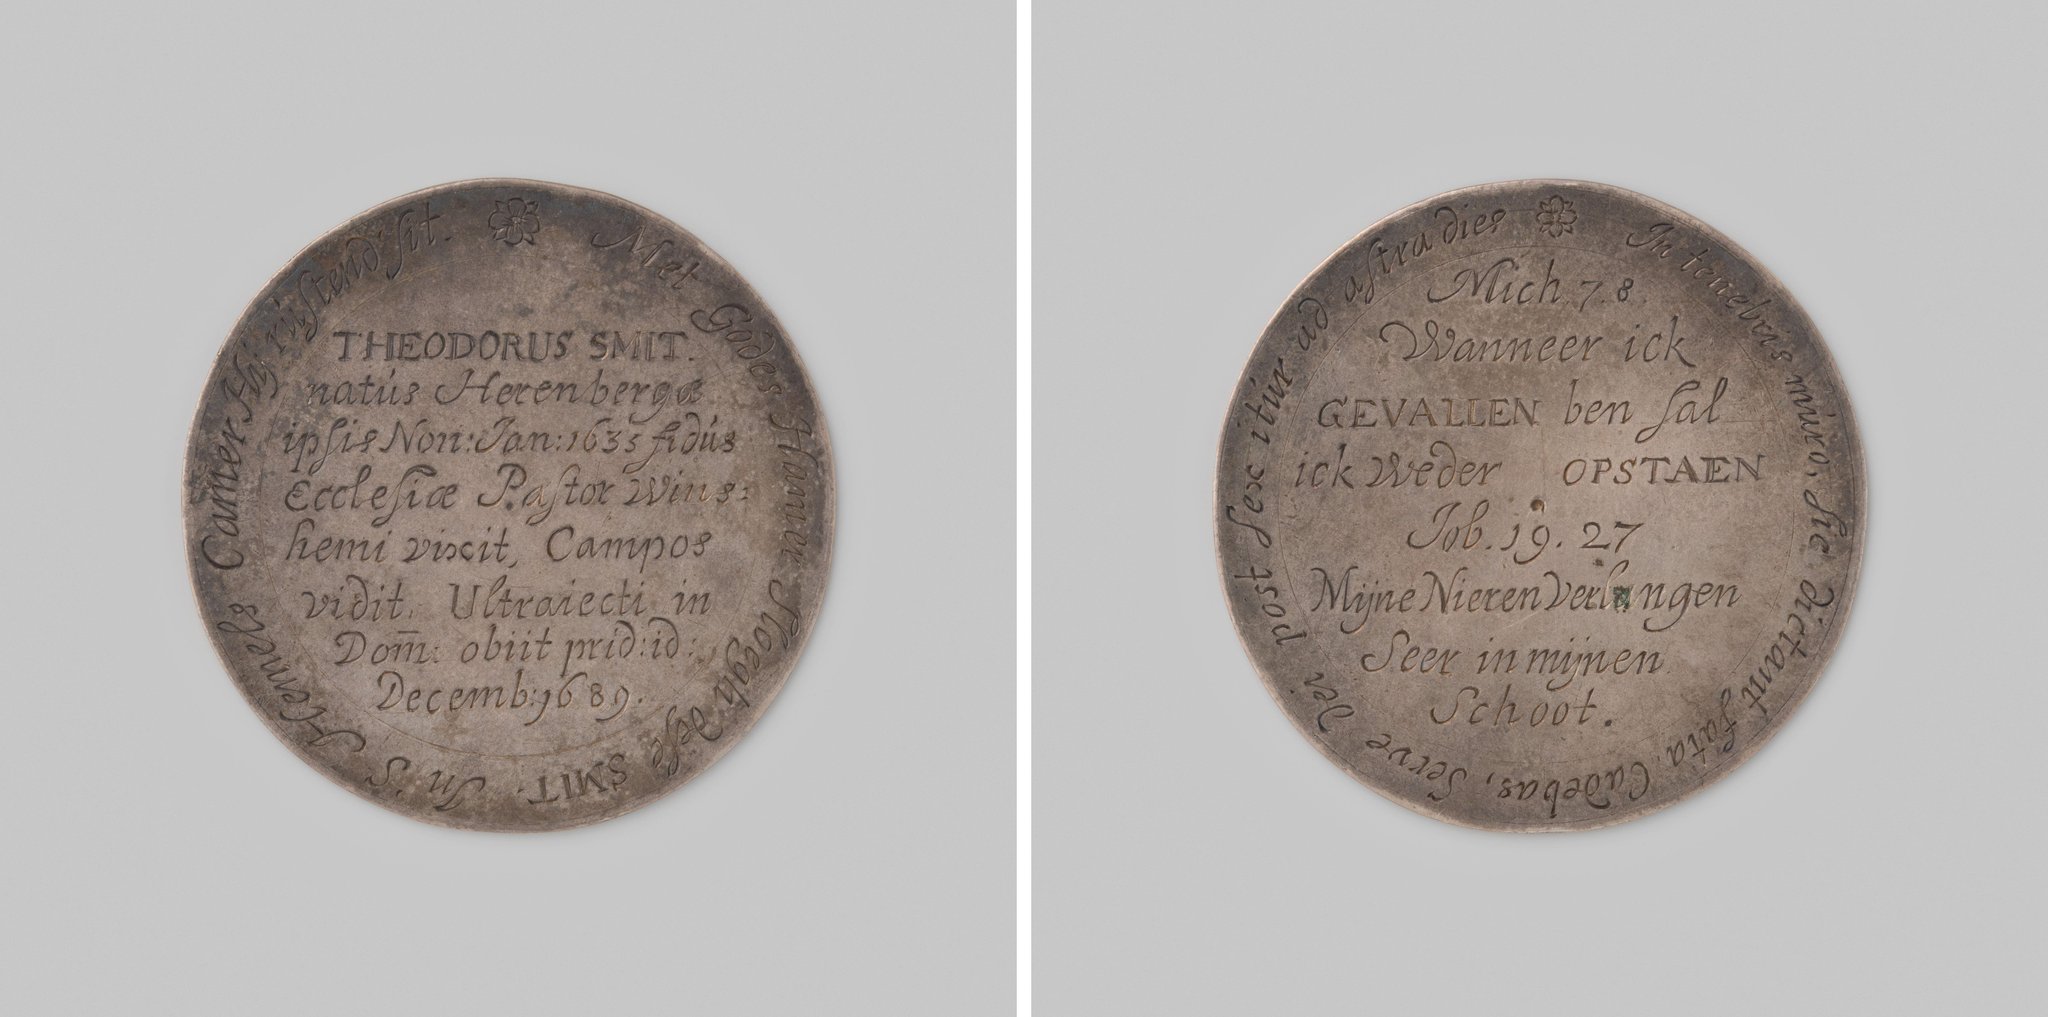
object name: family medal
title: Overlijden van Theodorus Smit 1689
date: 1689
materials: silver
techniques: engraving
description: Ronde zilveren plaat, beiderzijds gegraveerd, op voor- en keerzijde acht regels tekst met omschrift.